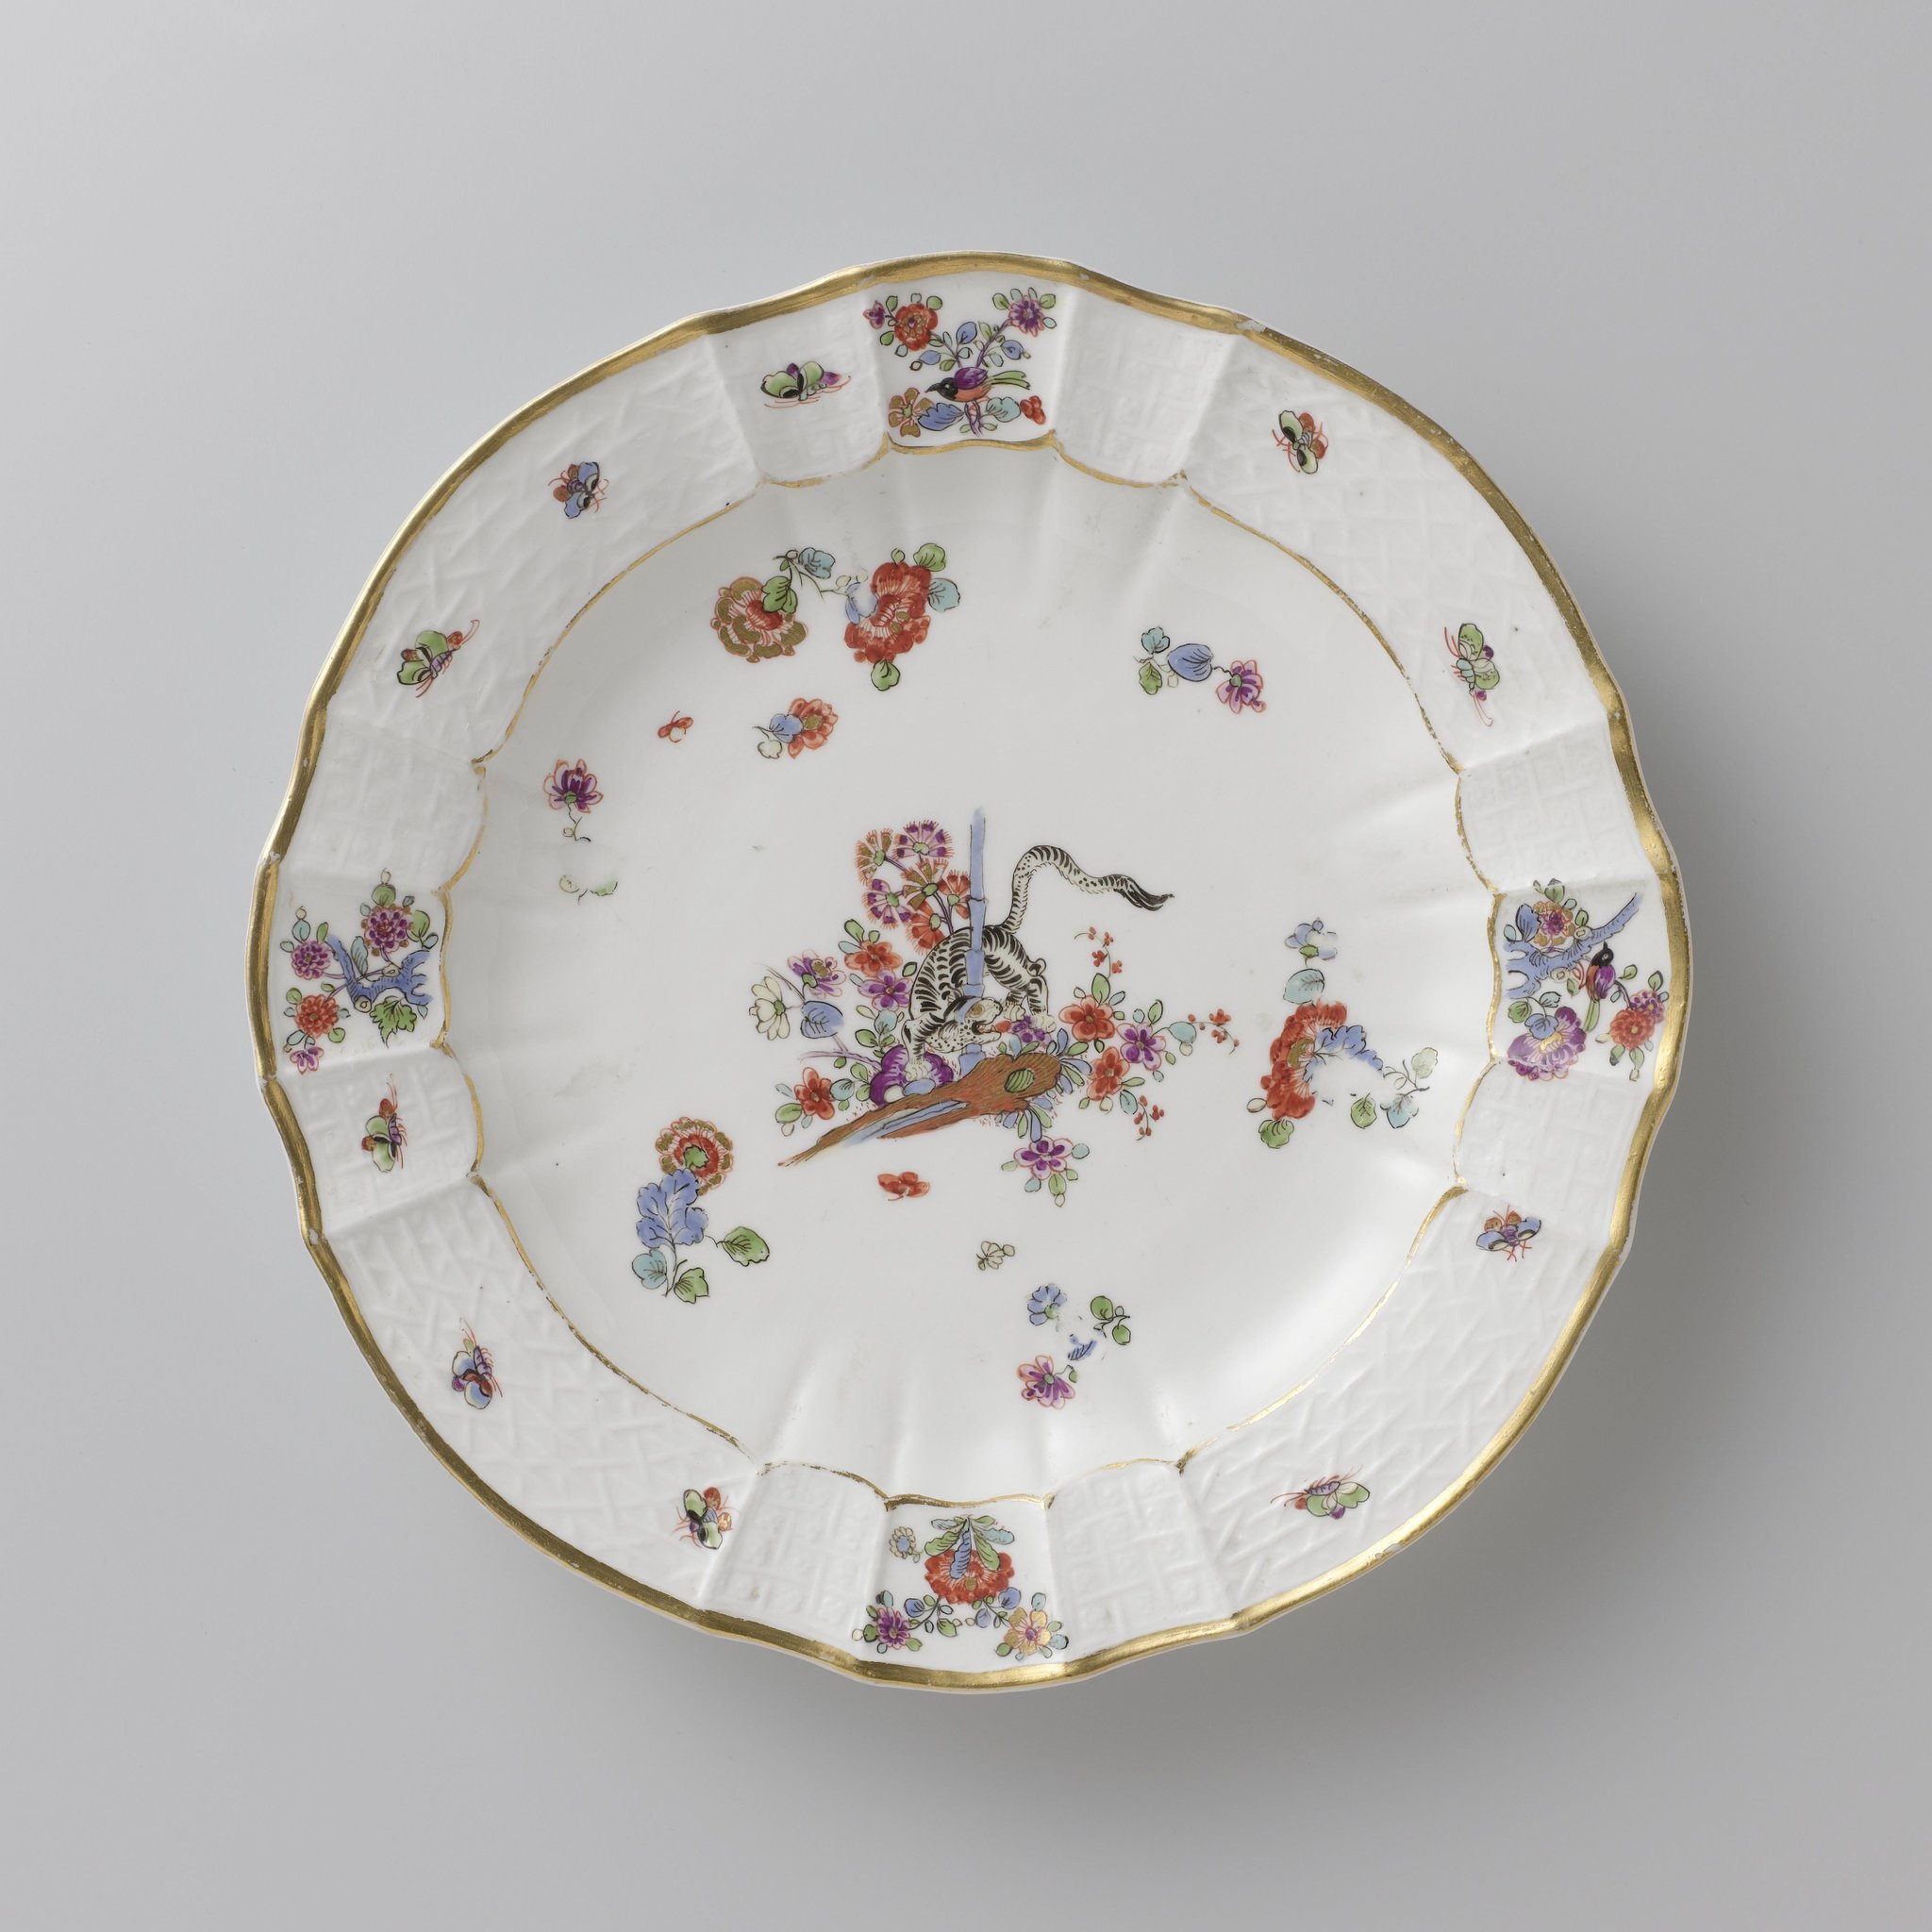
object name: plate dish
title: Rond bord, veelkleurig beschilderd met een Kakiemon-decor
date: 1740-1745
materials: porcelain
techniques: painted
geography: meissen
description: Rond bord van beschilderd porselein. Het bord is geribd en heeft een geschulpte rand. Het bord is beschilderd met een tijger die om een blauwe bamboestengel tussen bloemen is gedraaid, gestrooide Indianische Blumen, vlinders en takken waarop vogels. De rand is versierd met het 'Altbrandenstein'-patroon. Het bord is gemerkt.